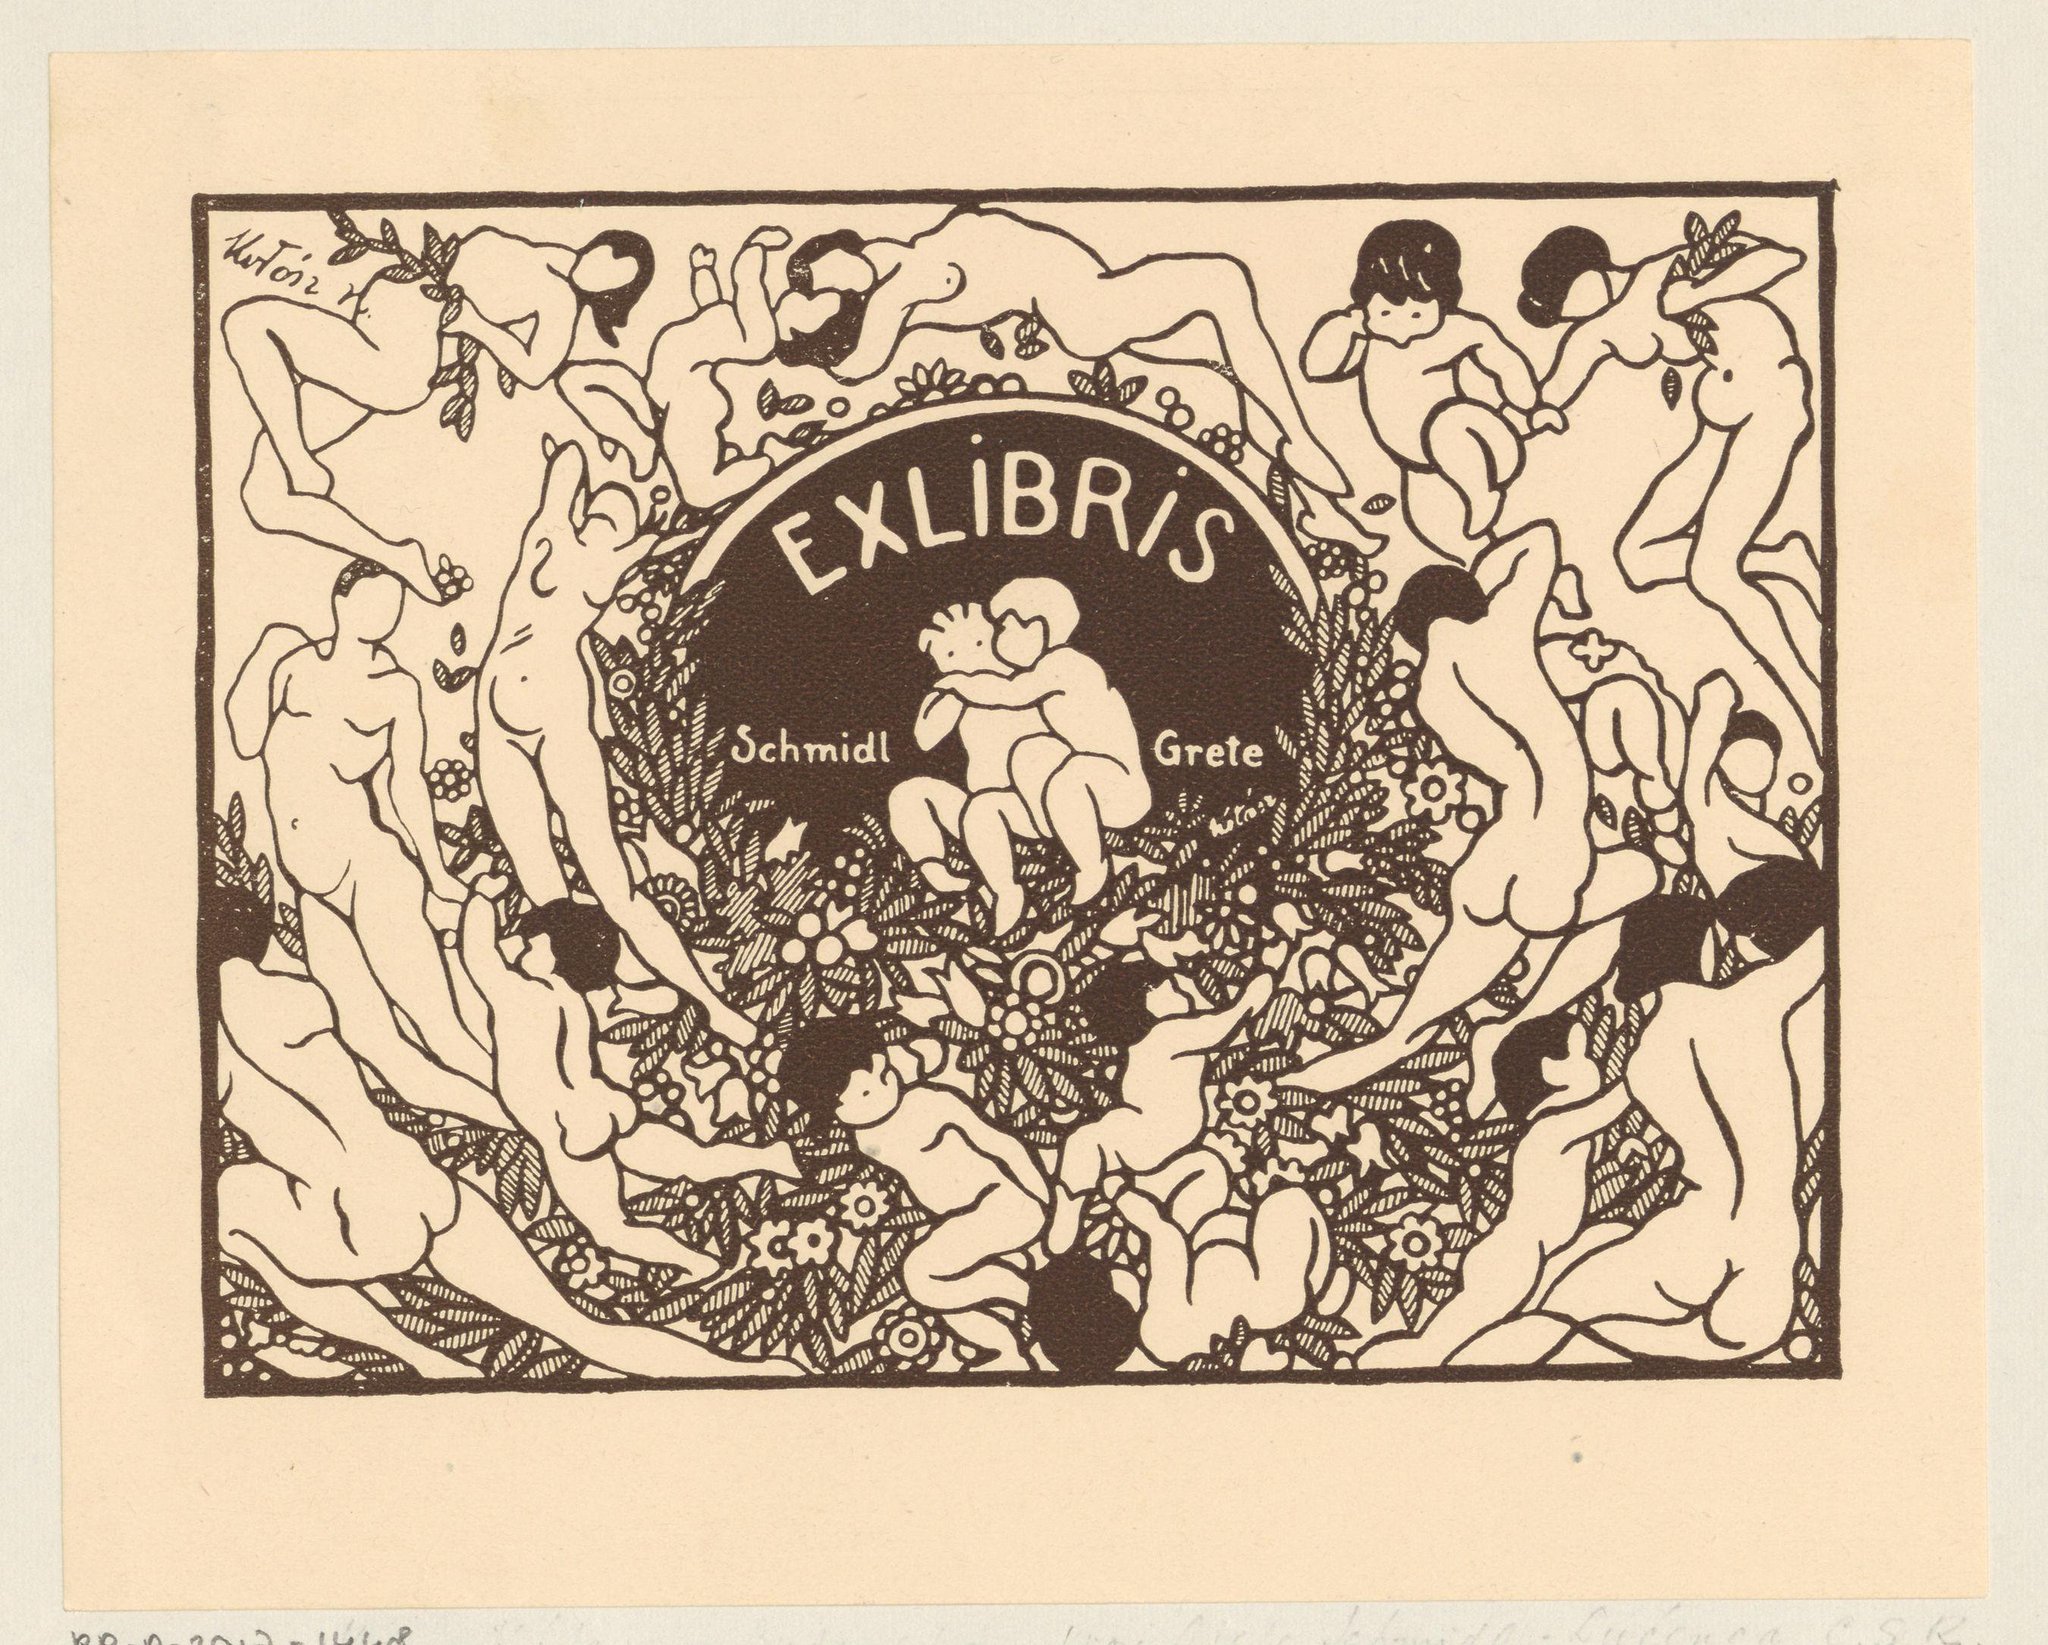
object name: bookplate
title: Ex libris van Grete Schmidl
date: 1932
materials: paper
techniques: printing block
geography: budapest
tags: flowers, woman (showing herself) undressed, quasi-nude, mother and baby or young child, infant, baby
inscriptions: inscription: ‘Karl Kotász Budapest 932’